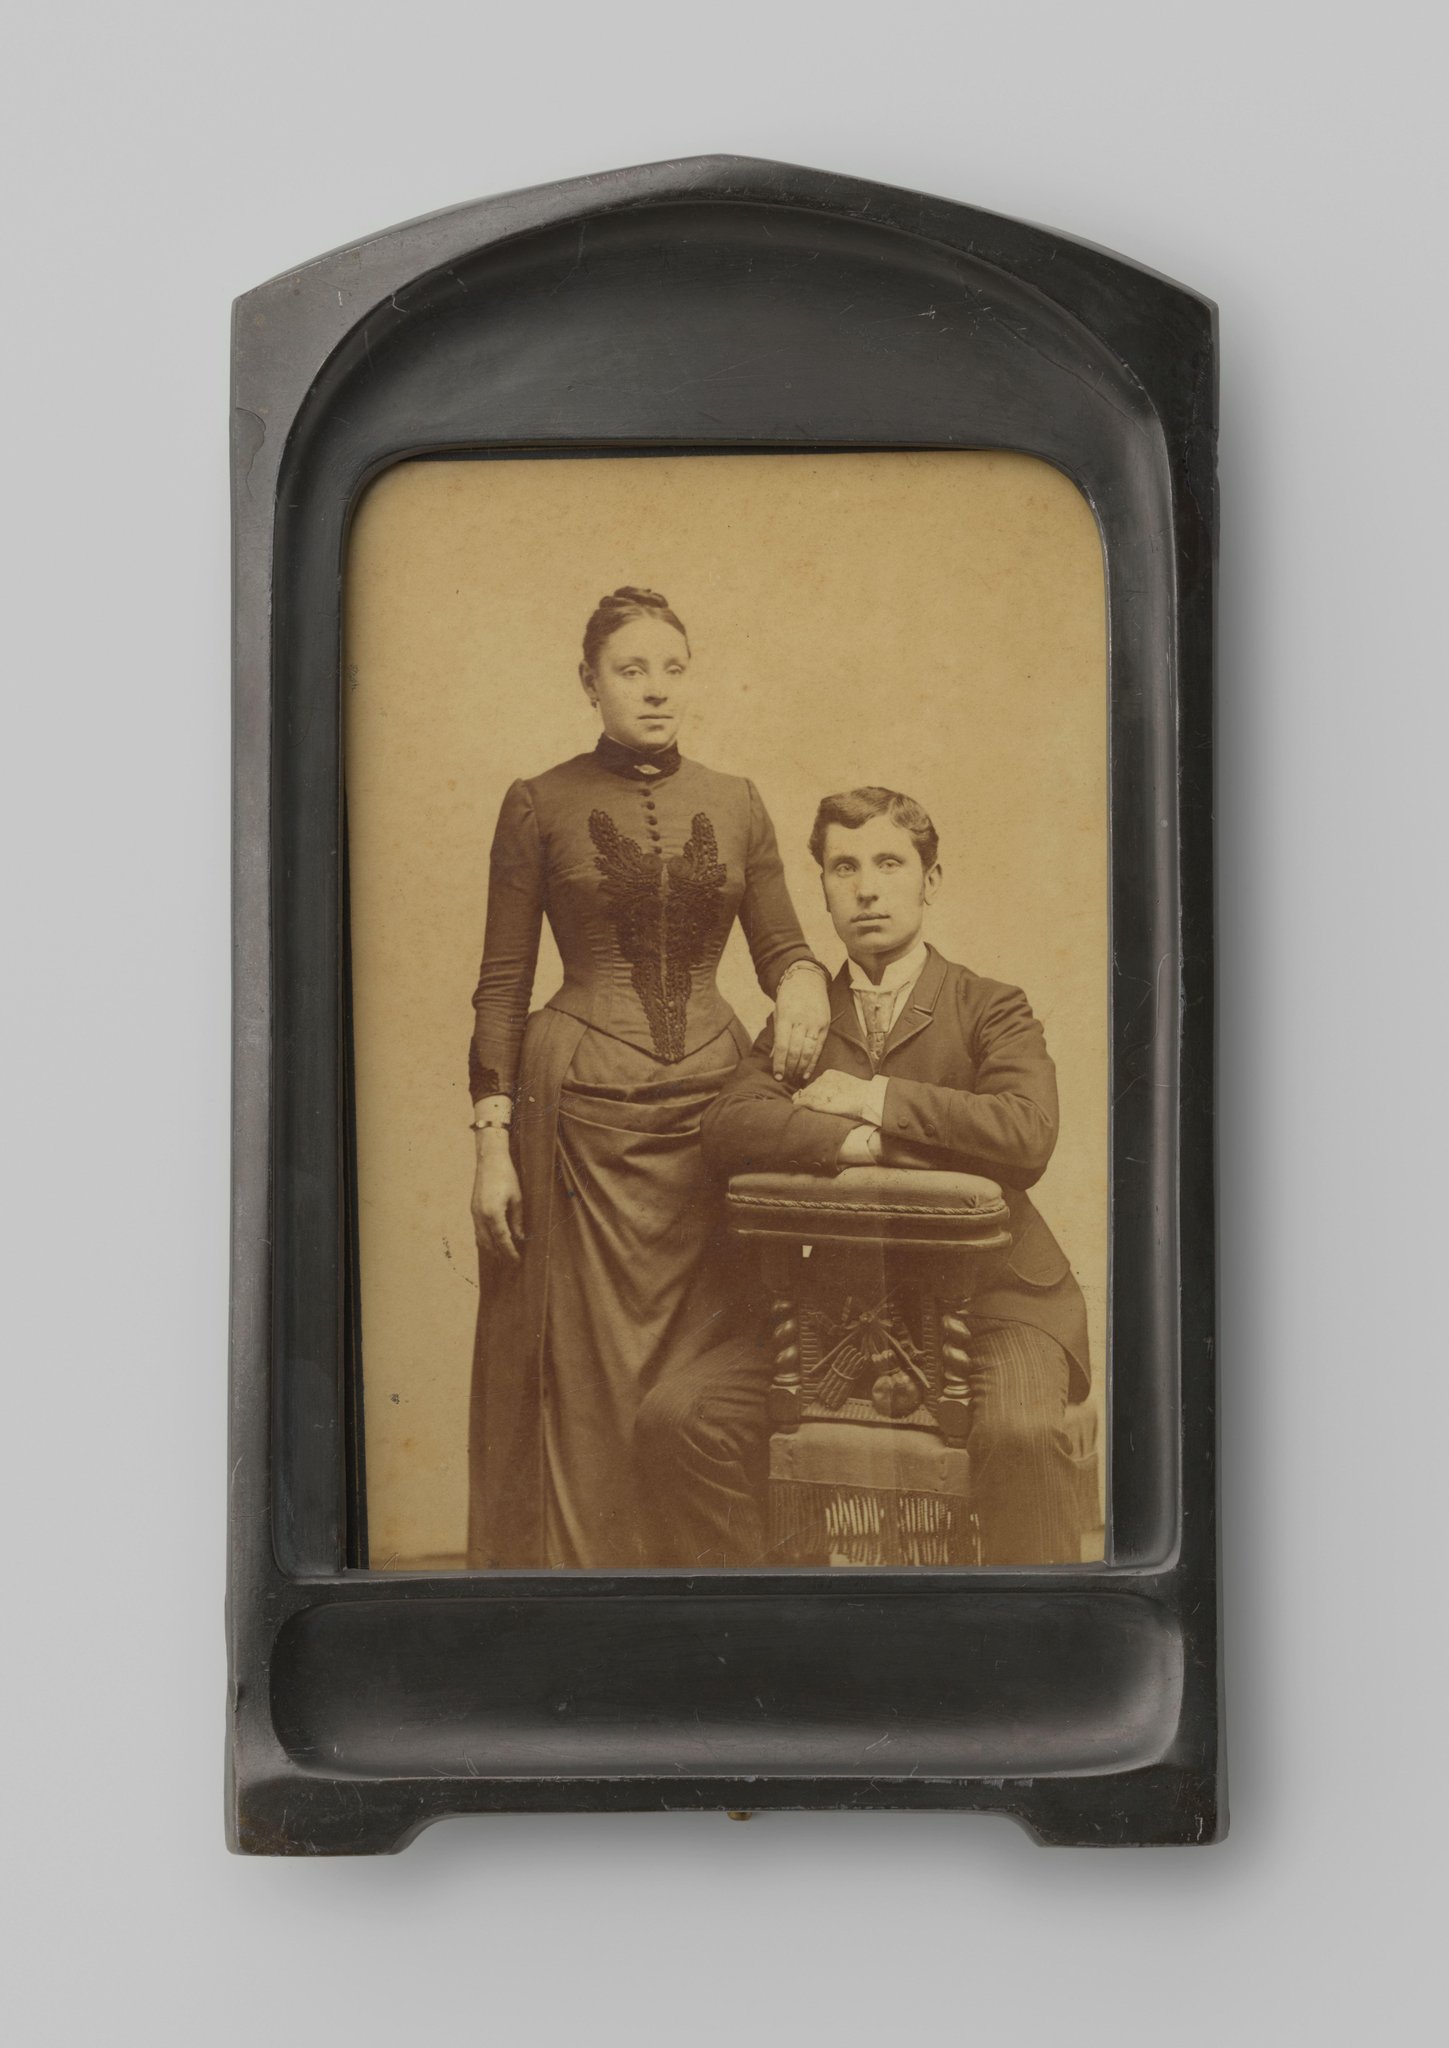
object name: photograph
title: Portret van een onbekende man en vrouw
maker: Anonymous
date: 1880-1900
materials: cardboard, glass, metal, paper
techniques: albumen print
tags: adult woman, adult man, anonymous historical person portrayed, couple of lovers